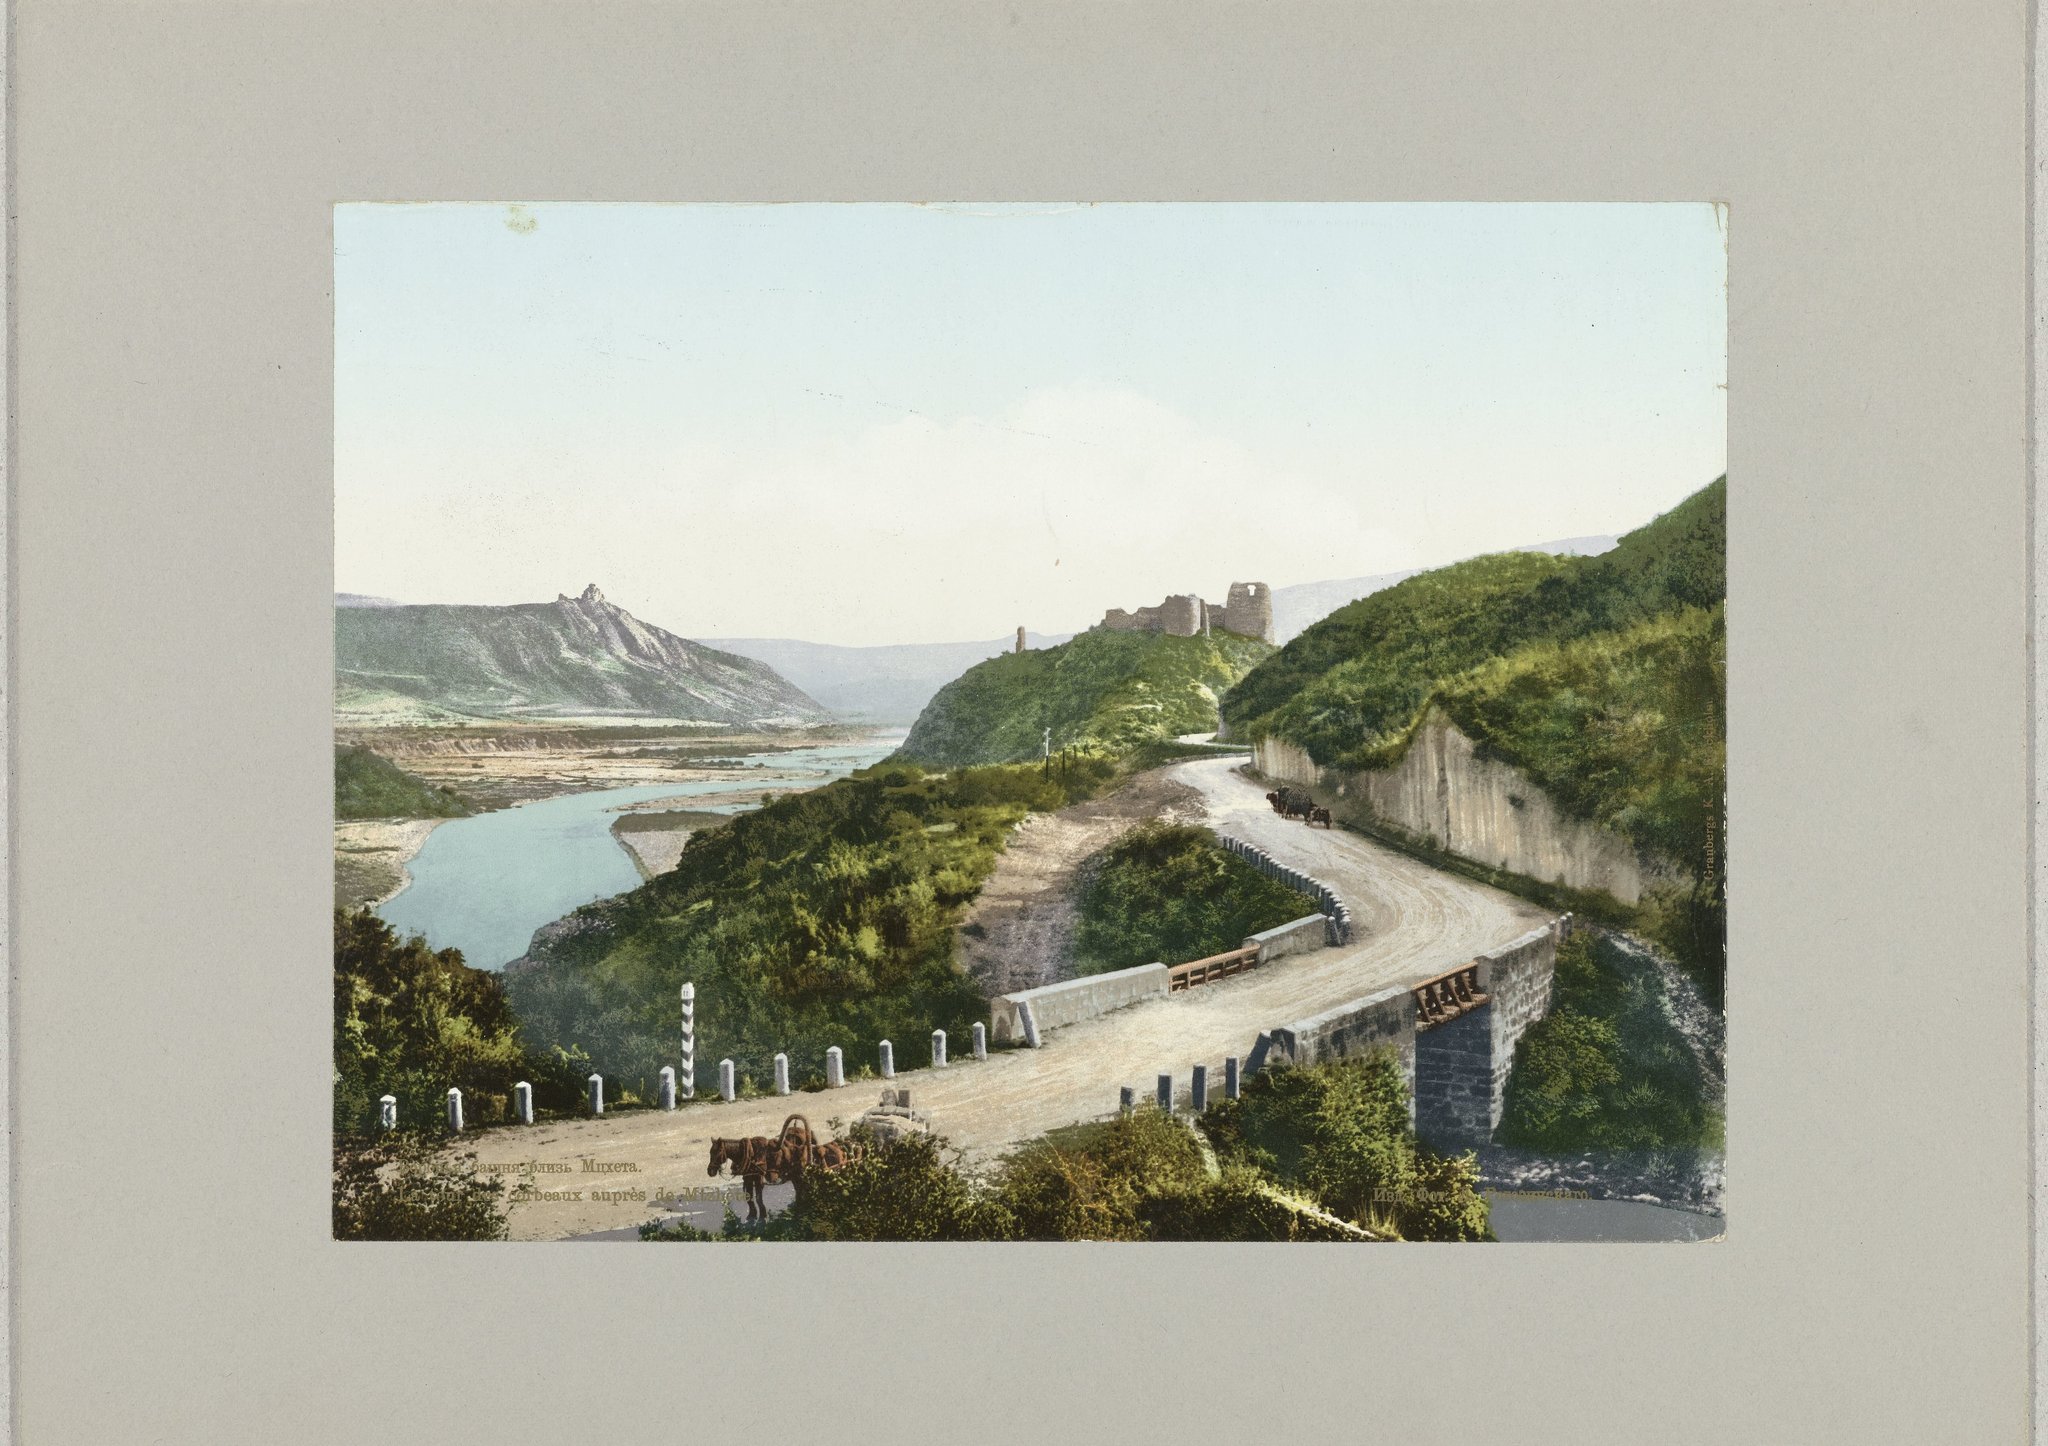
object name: photograph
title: Weg over rivier nabij Mtscheta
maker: Anonymous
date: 1895-1915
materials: cardboard, paper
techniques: photolithography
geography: georgia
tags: georgië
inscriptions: annotation: ‘40. idem.’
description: Weg waarop linksonder twee paarden voor een wagen gespannen staan, daarnaast staat de titel in het Russisch en in het Frans.